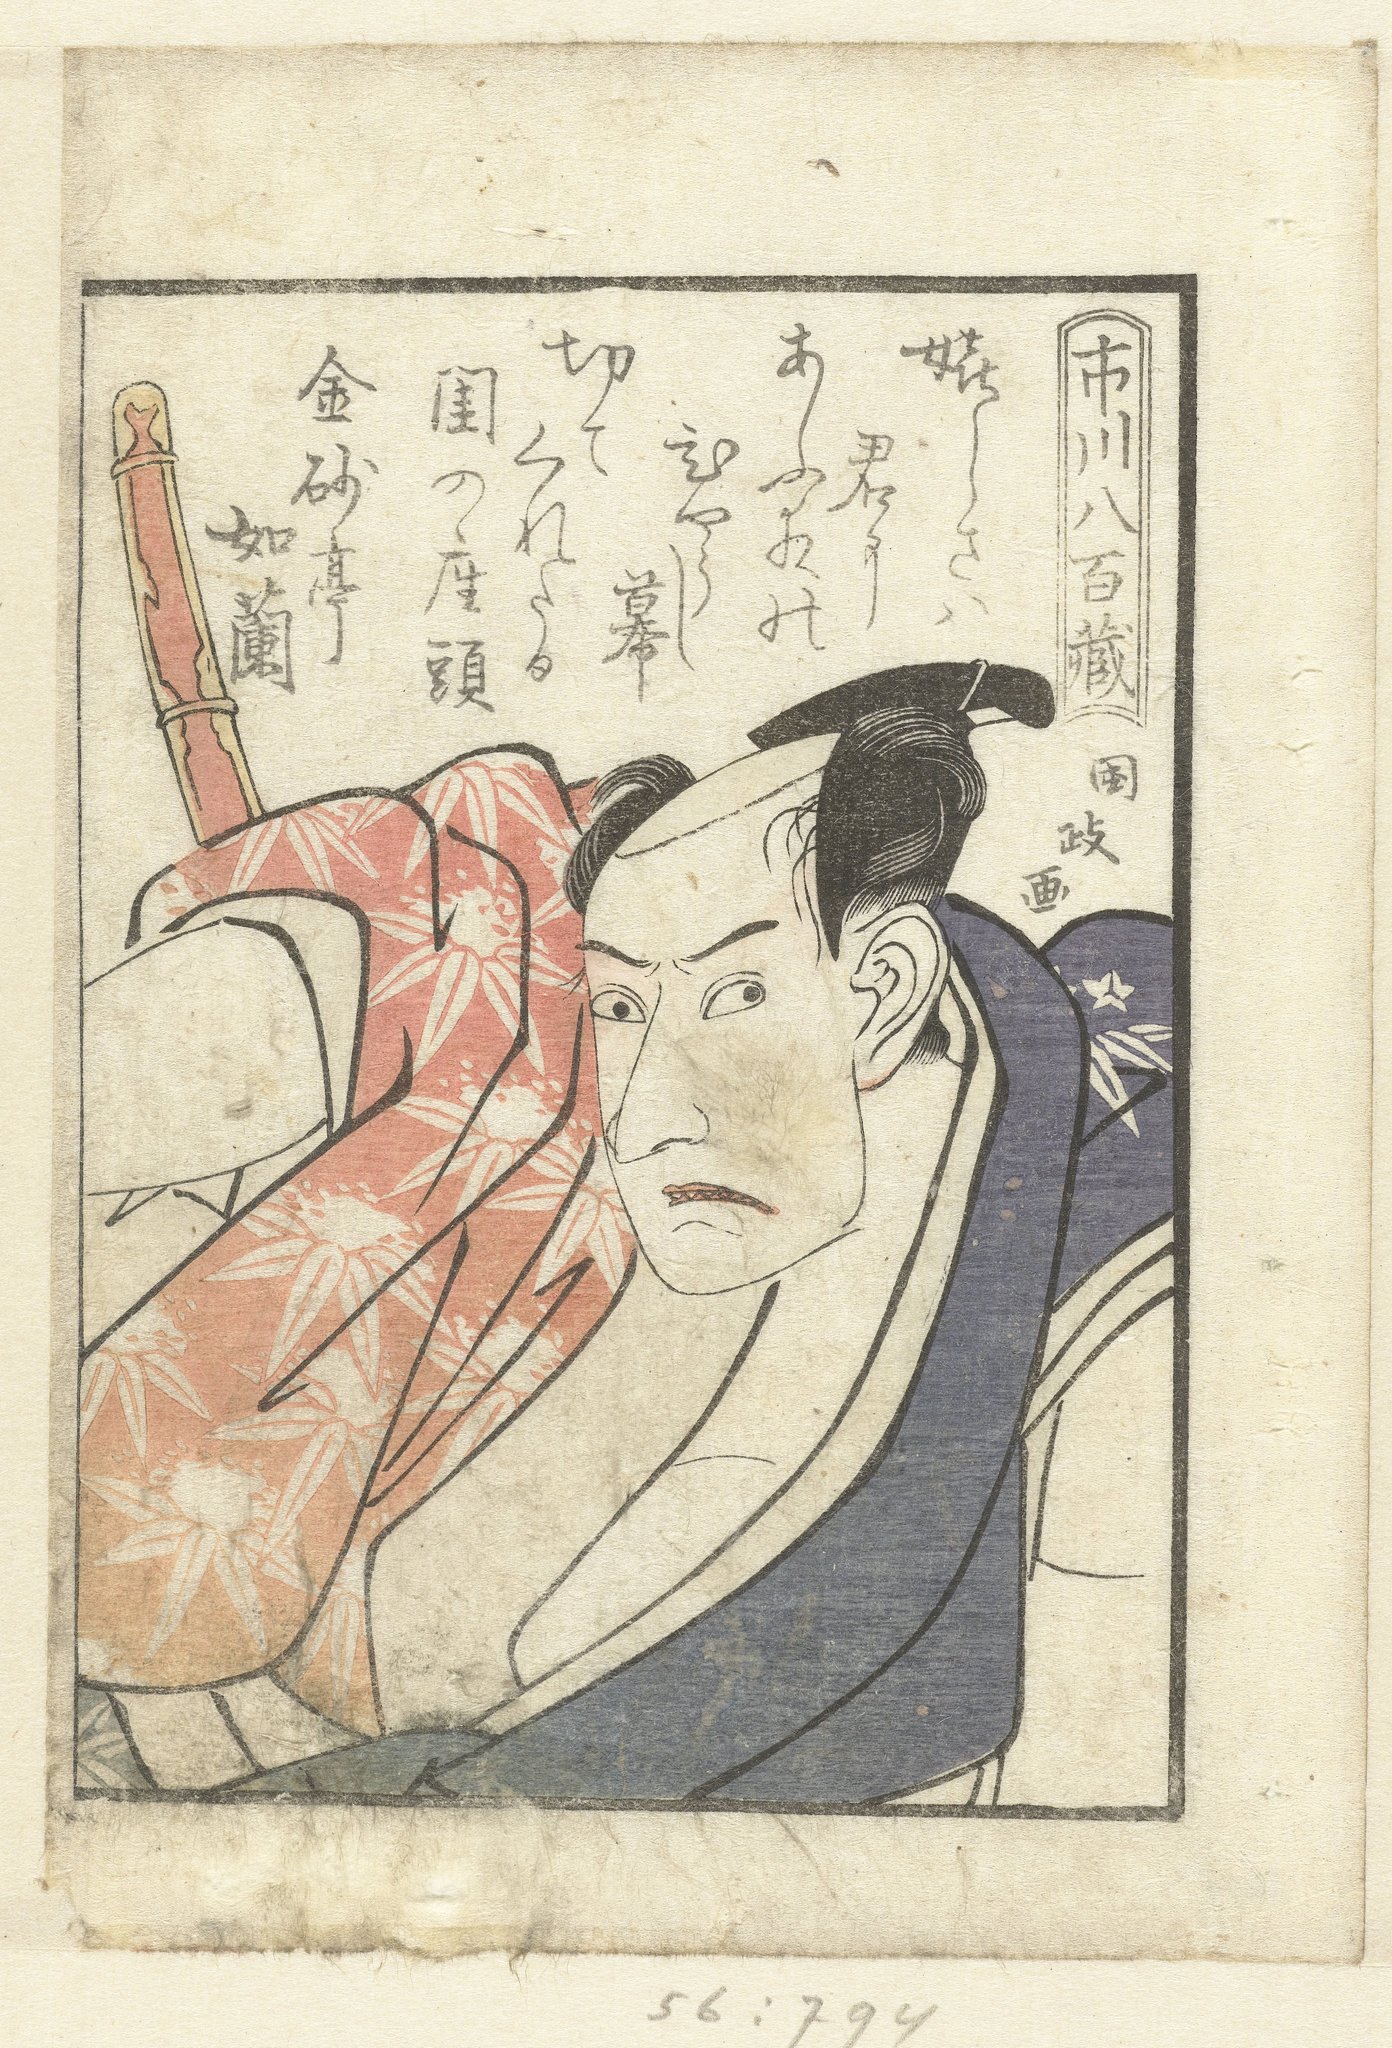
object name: print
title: Ichikawa Yaozo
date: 1799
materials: paper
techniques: woodcut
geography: edo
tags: portrait of actor, actress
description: Busteportret van de acteur Ichikawa Yaozo III, in paarse en rode kimono, met zwaard op de rug, afgebeeld onder een aan hem gericht liefdesgedicht. Blad uit het Japanse boek Yakusha gakuya tsu.